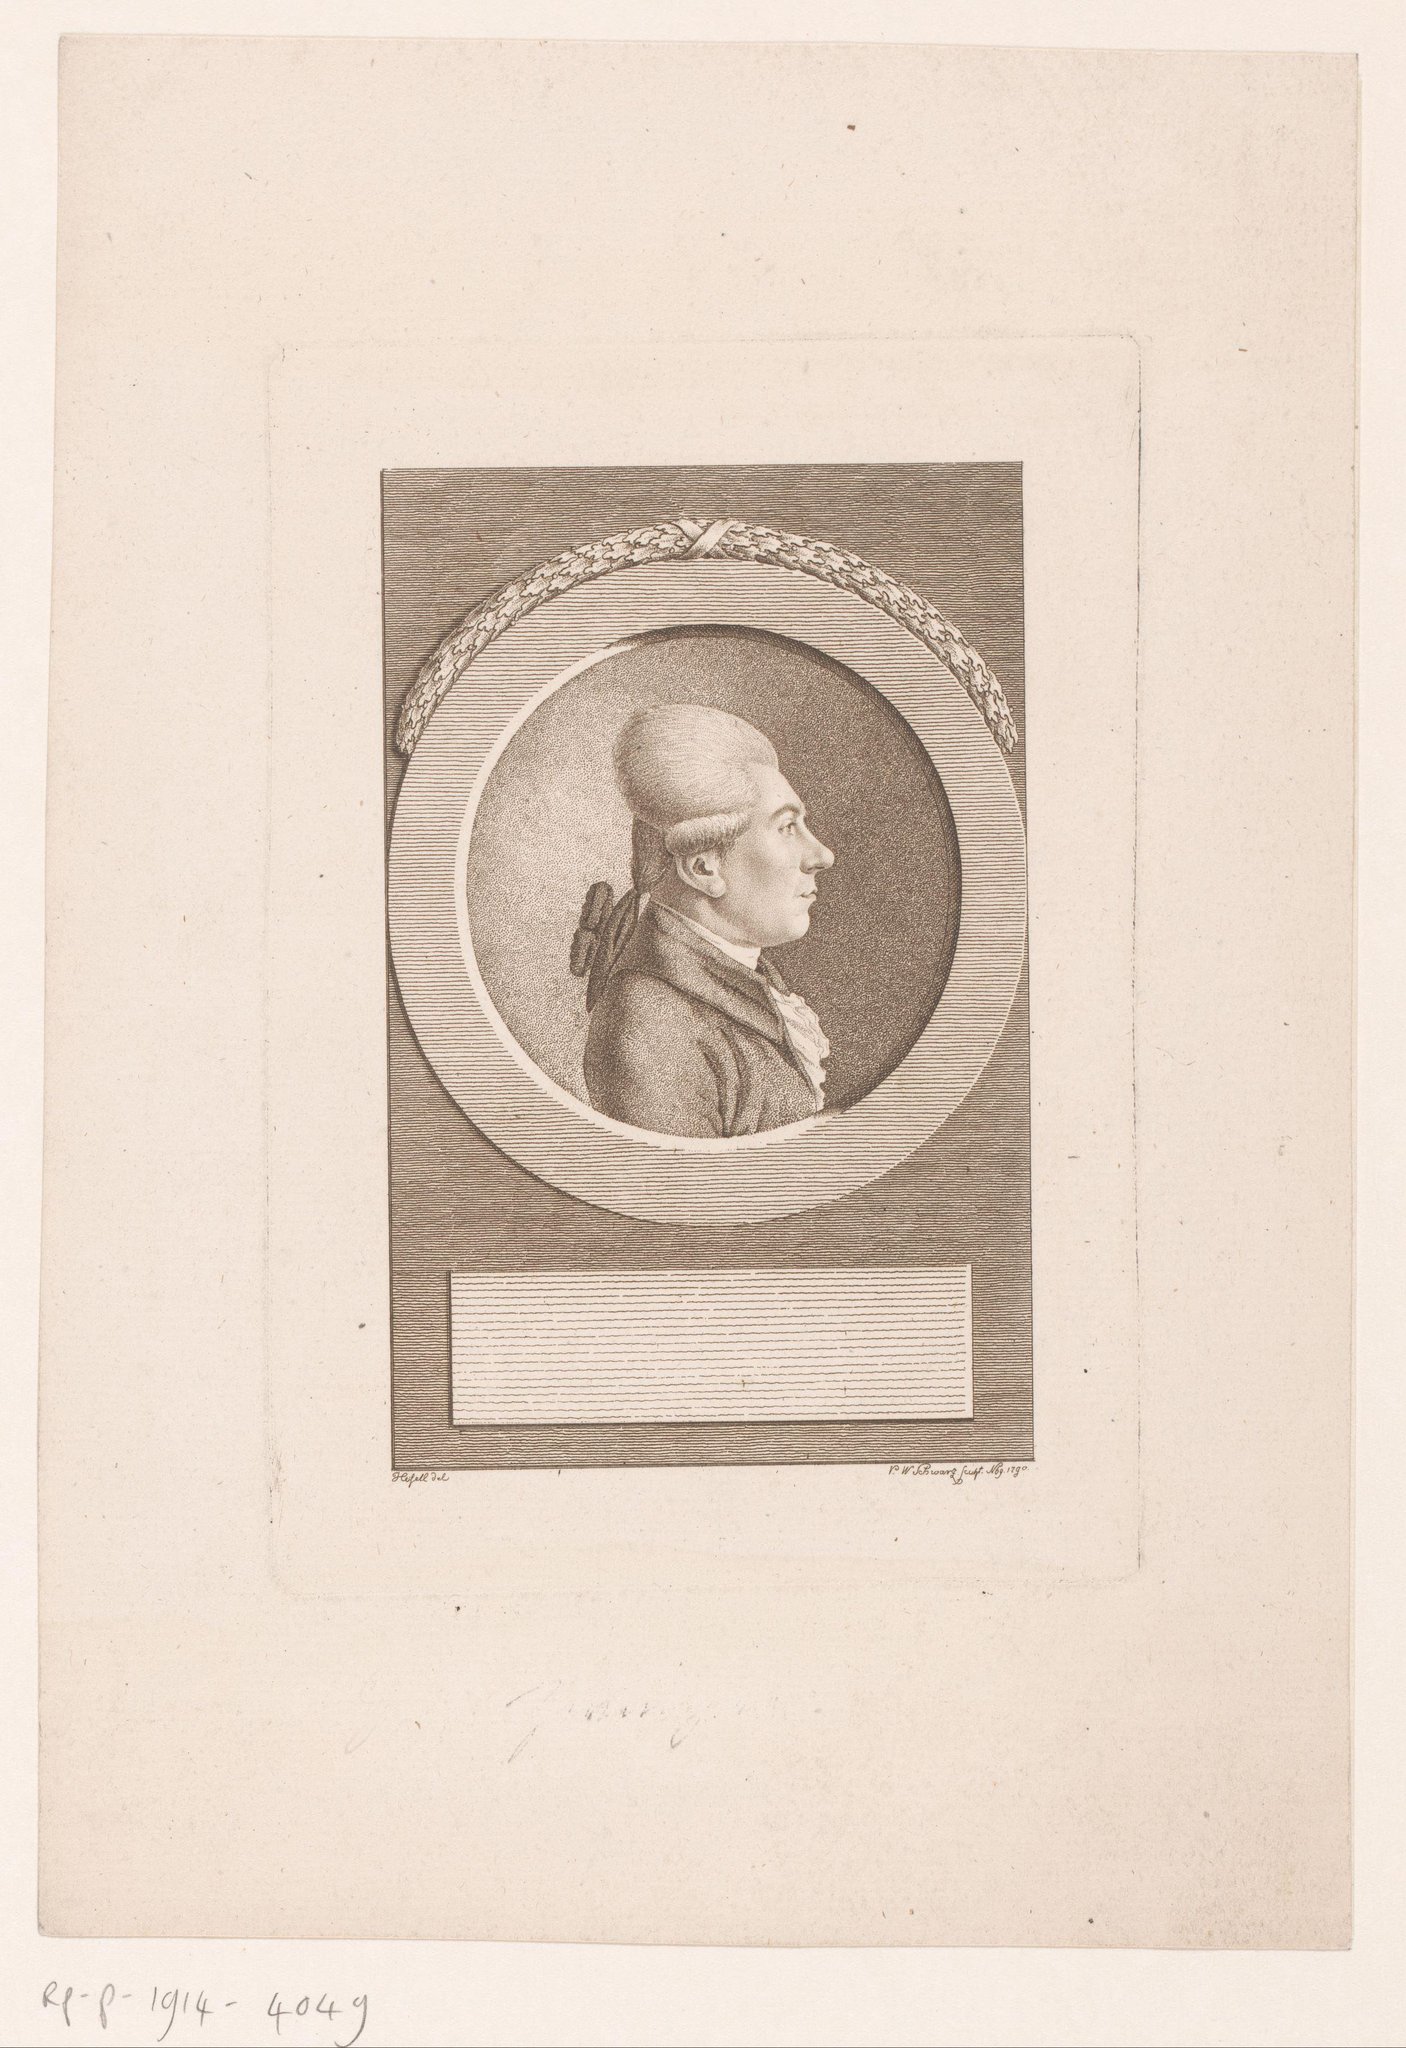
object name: print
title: Portret van Georg Wolfgang Franz Panzer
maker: paul wolfgang schwarz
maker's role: print maker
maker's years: -1815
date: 1790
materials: paper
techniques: engraving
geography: nuremberg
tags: historical persons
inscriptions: collector's mark: Lugt 2228